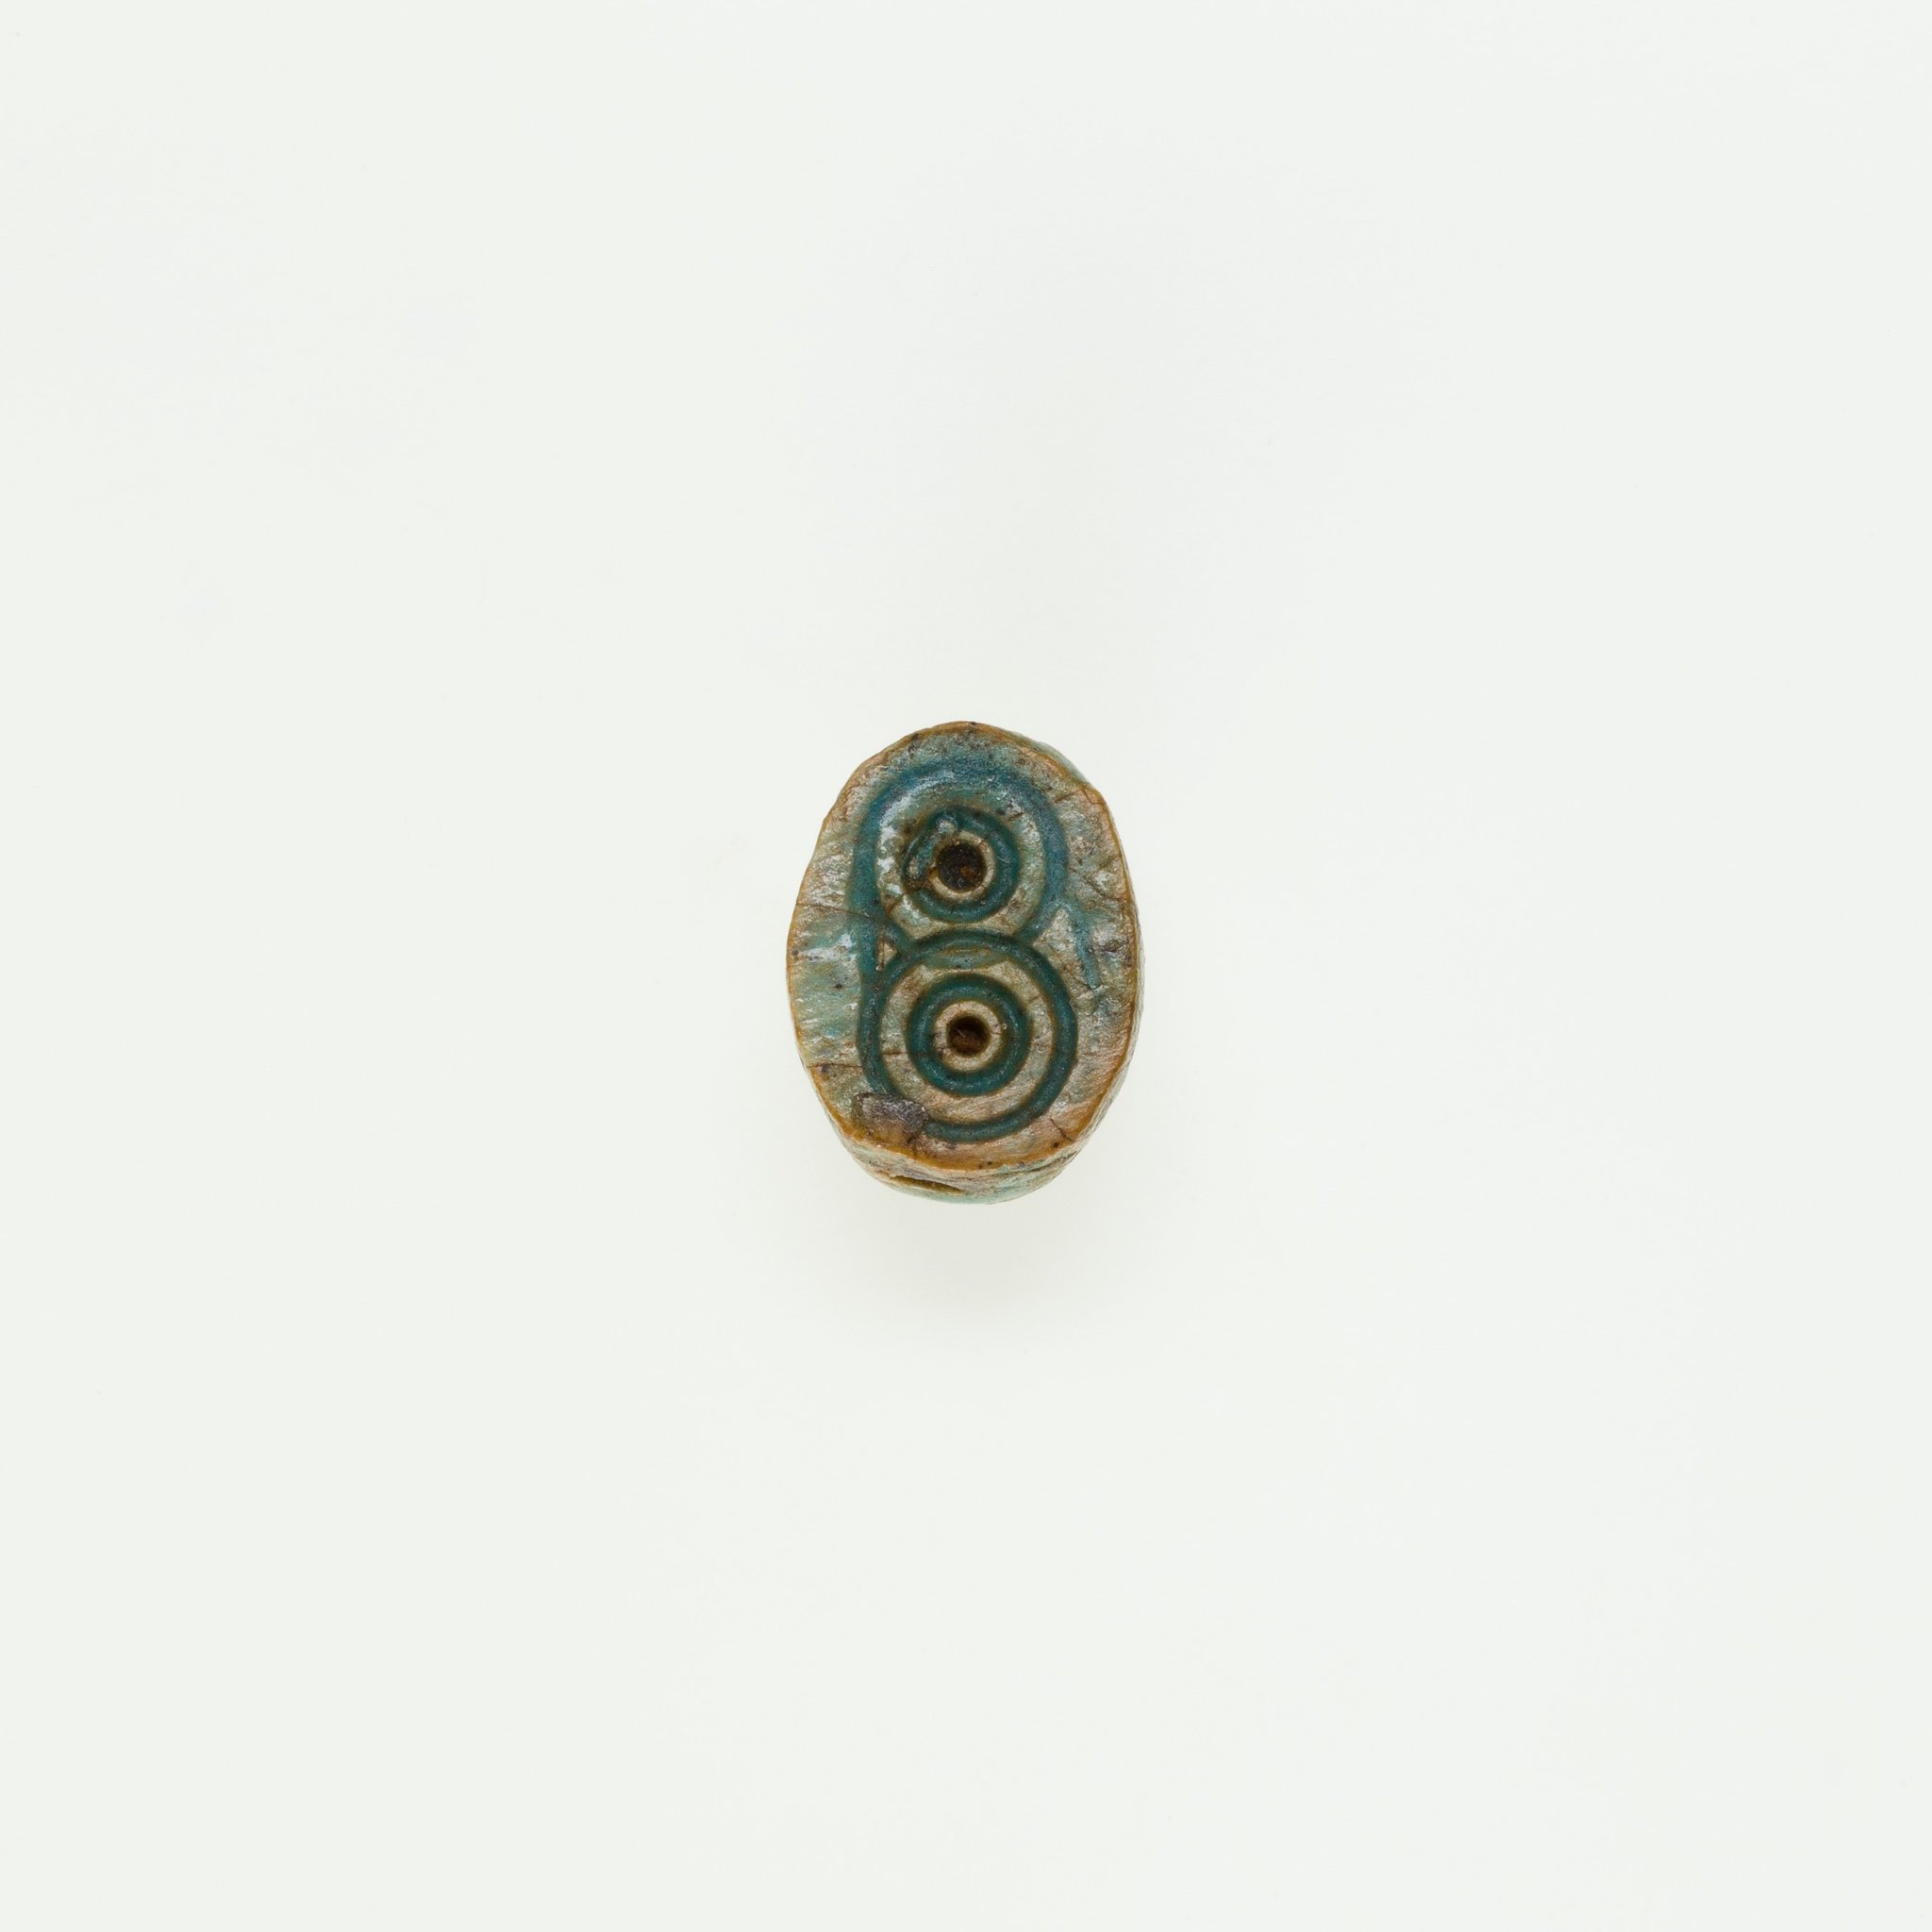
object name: scarab, circle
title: Scarab Decorated with Circles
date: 1640-1550 BCE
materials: stone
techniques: glazing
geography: egypt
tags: scarabs